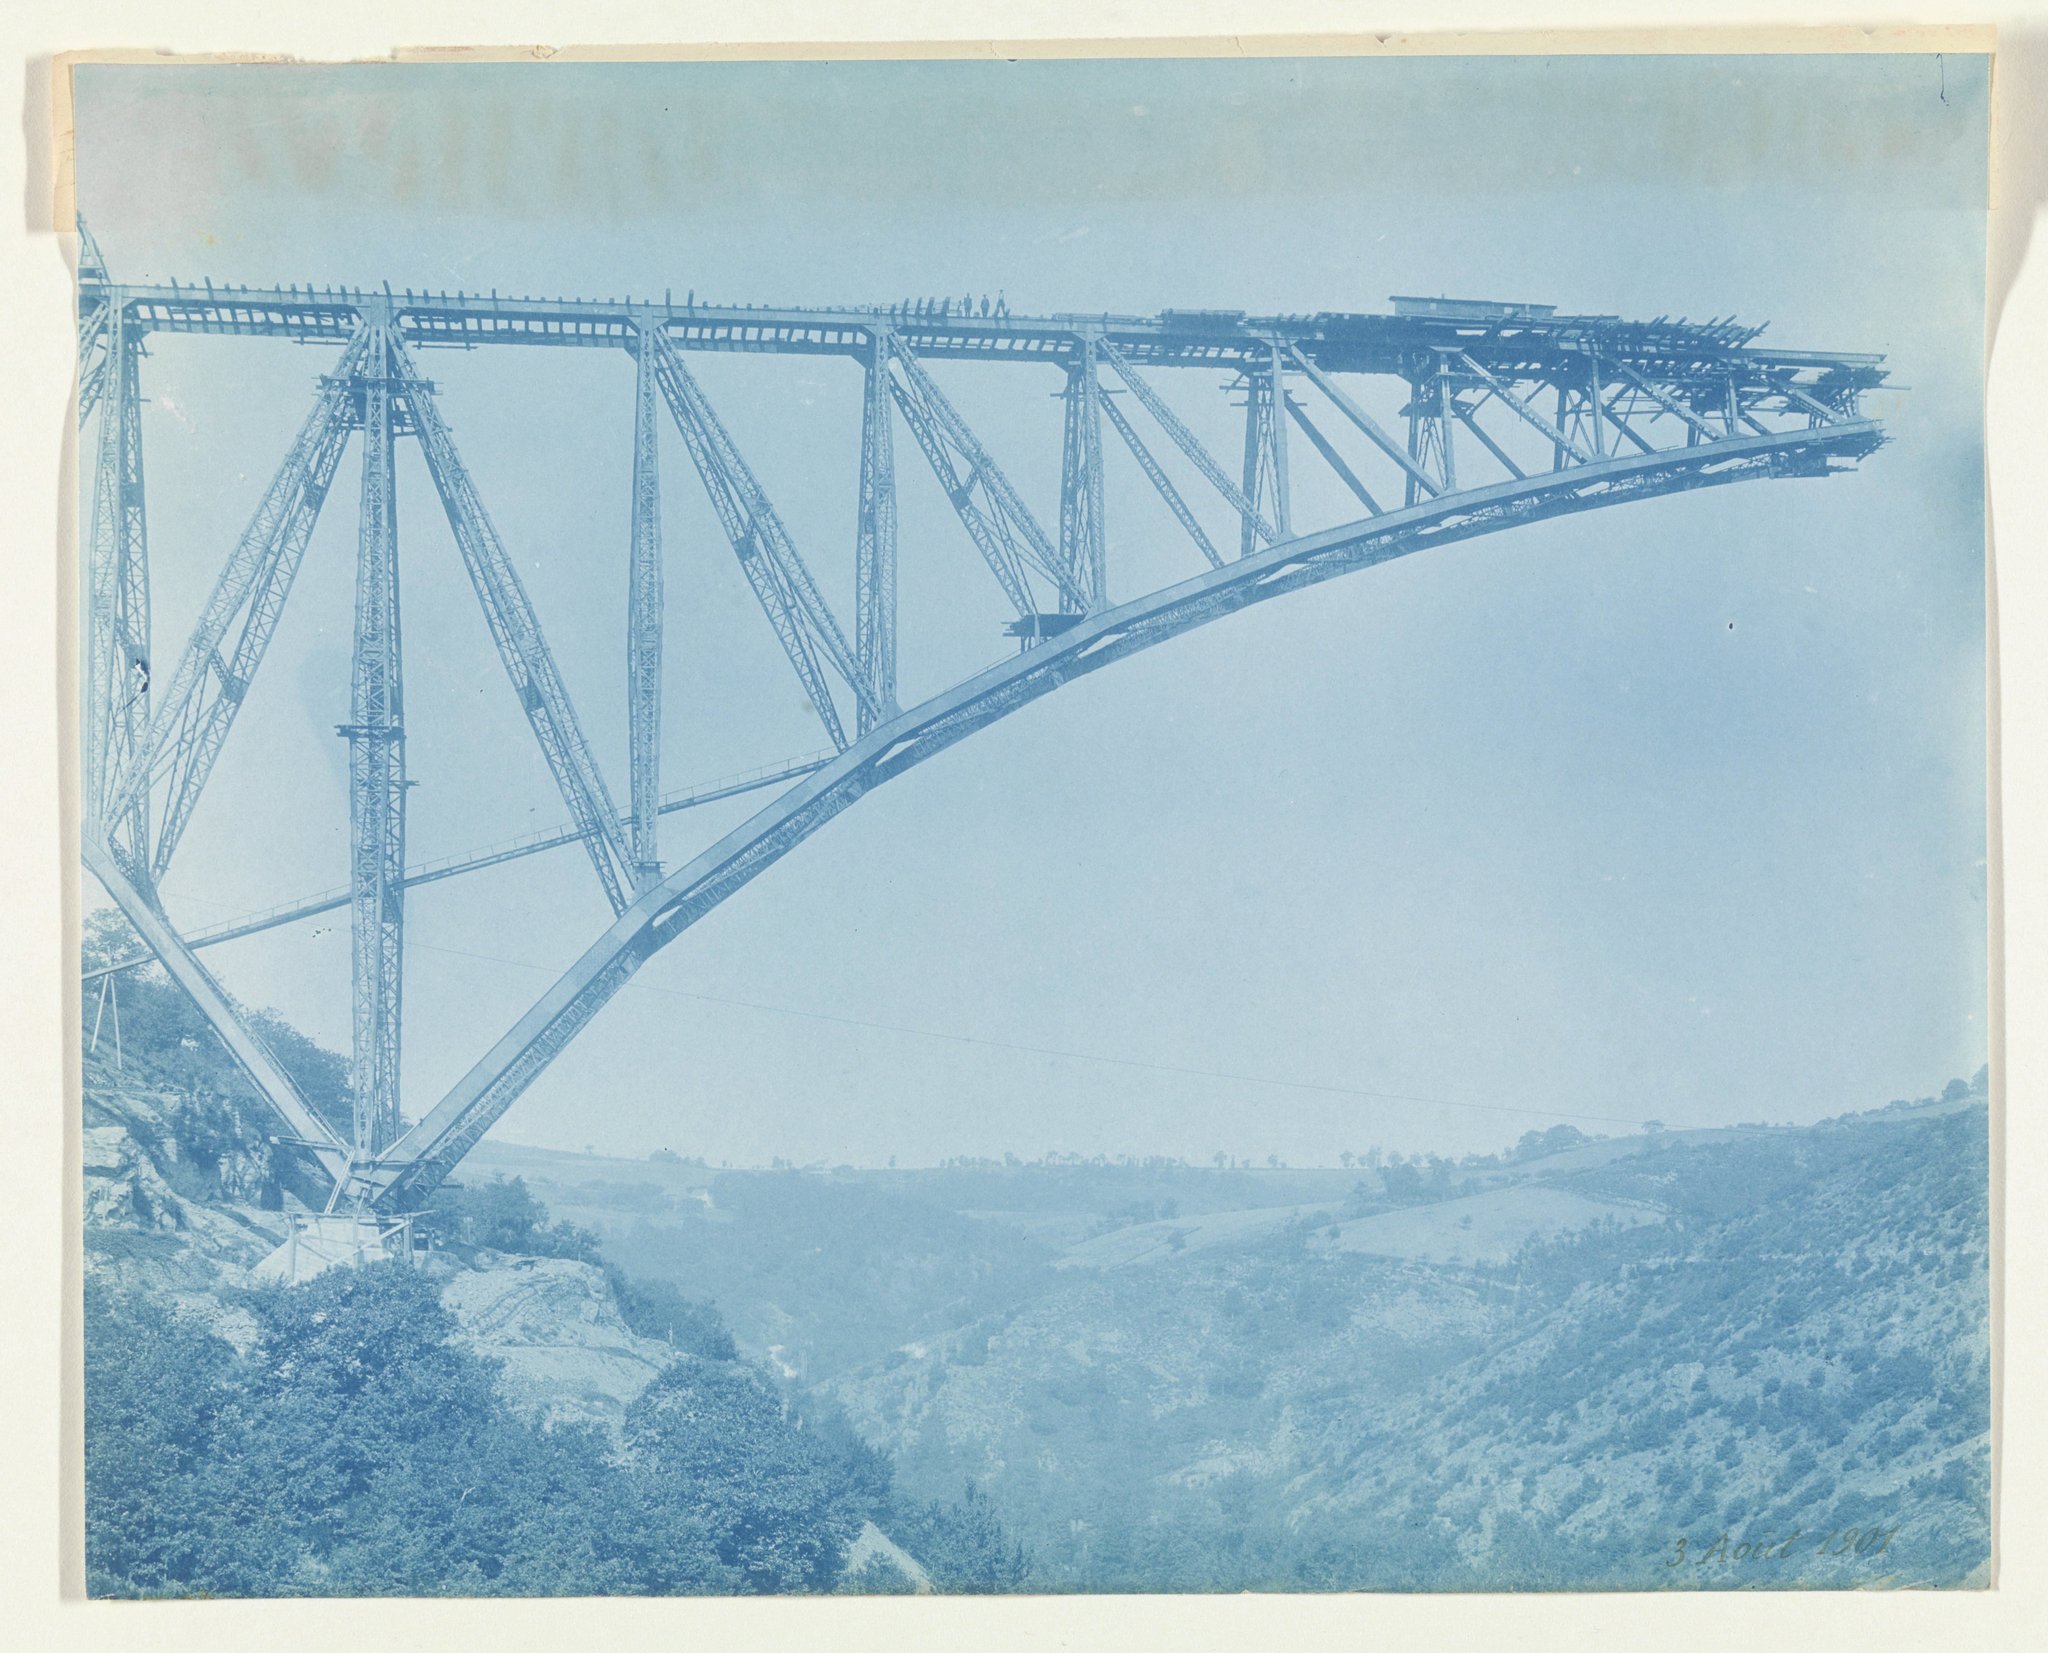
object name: photograph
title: Aanleg van het Viaur Viaduct in Frankrijk door de Societé de Construction des Battignolles, 3 augustus 1901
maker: Anonymous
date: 1901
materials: photographic support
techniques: cyanotype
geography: france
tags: viaduct, making the overground structures (~ building activities)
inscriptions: date